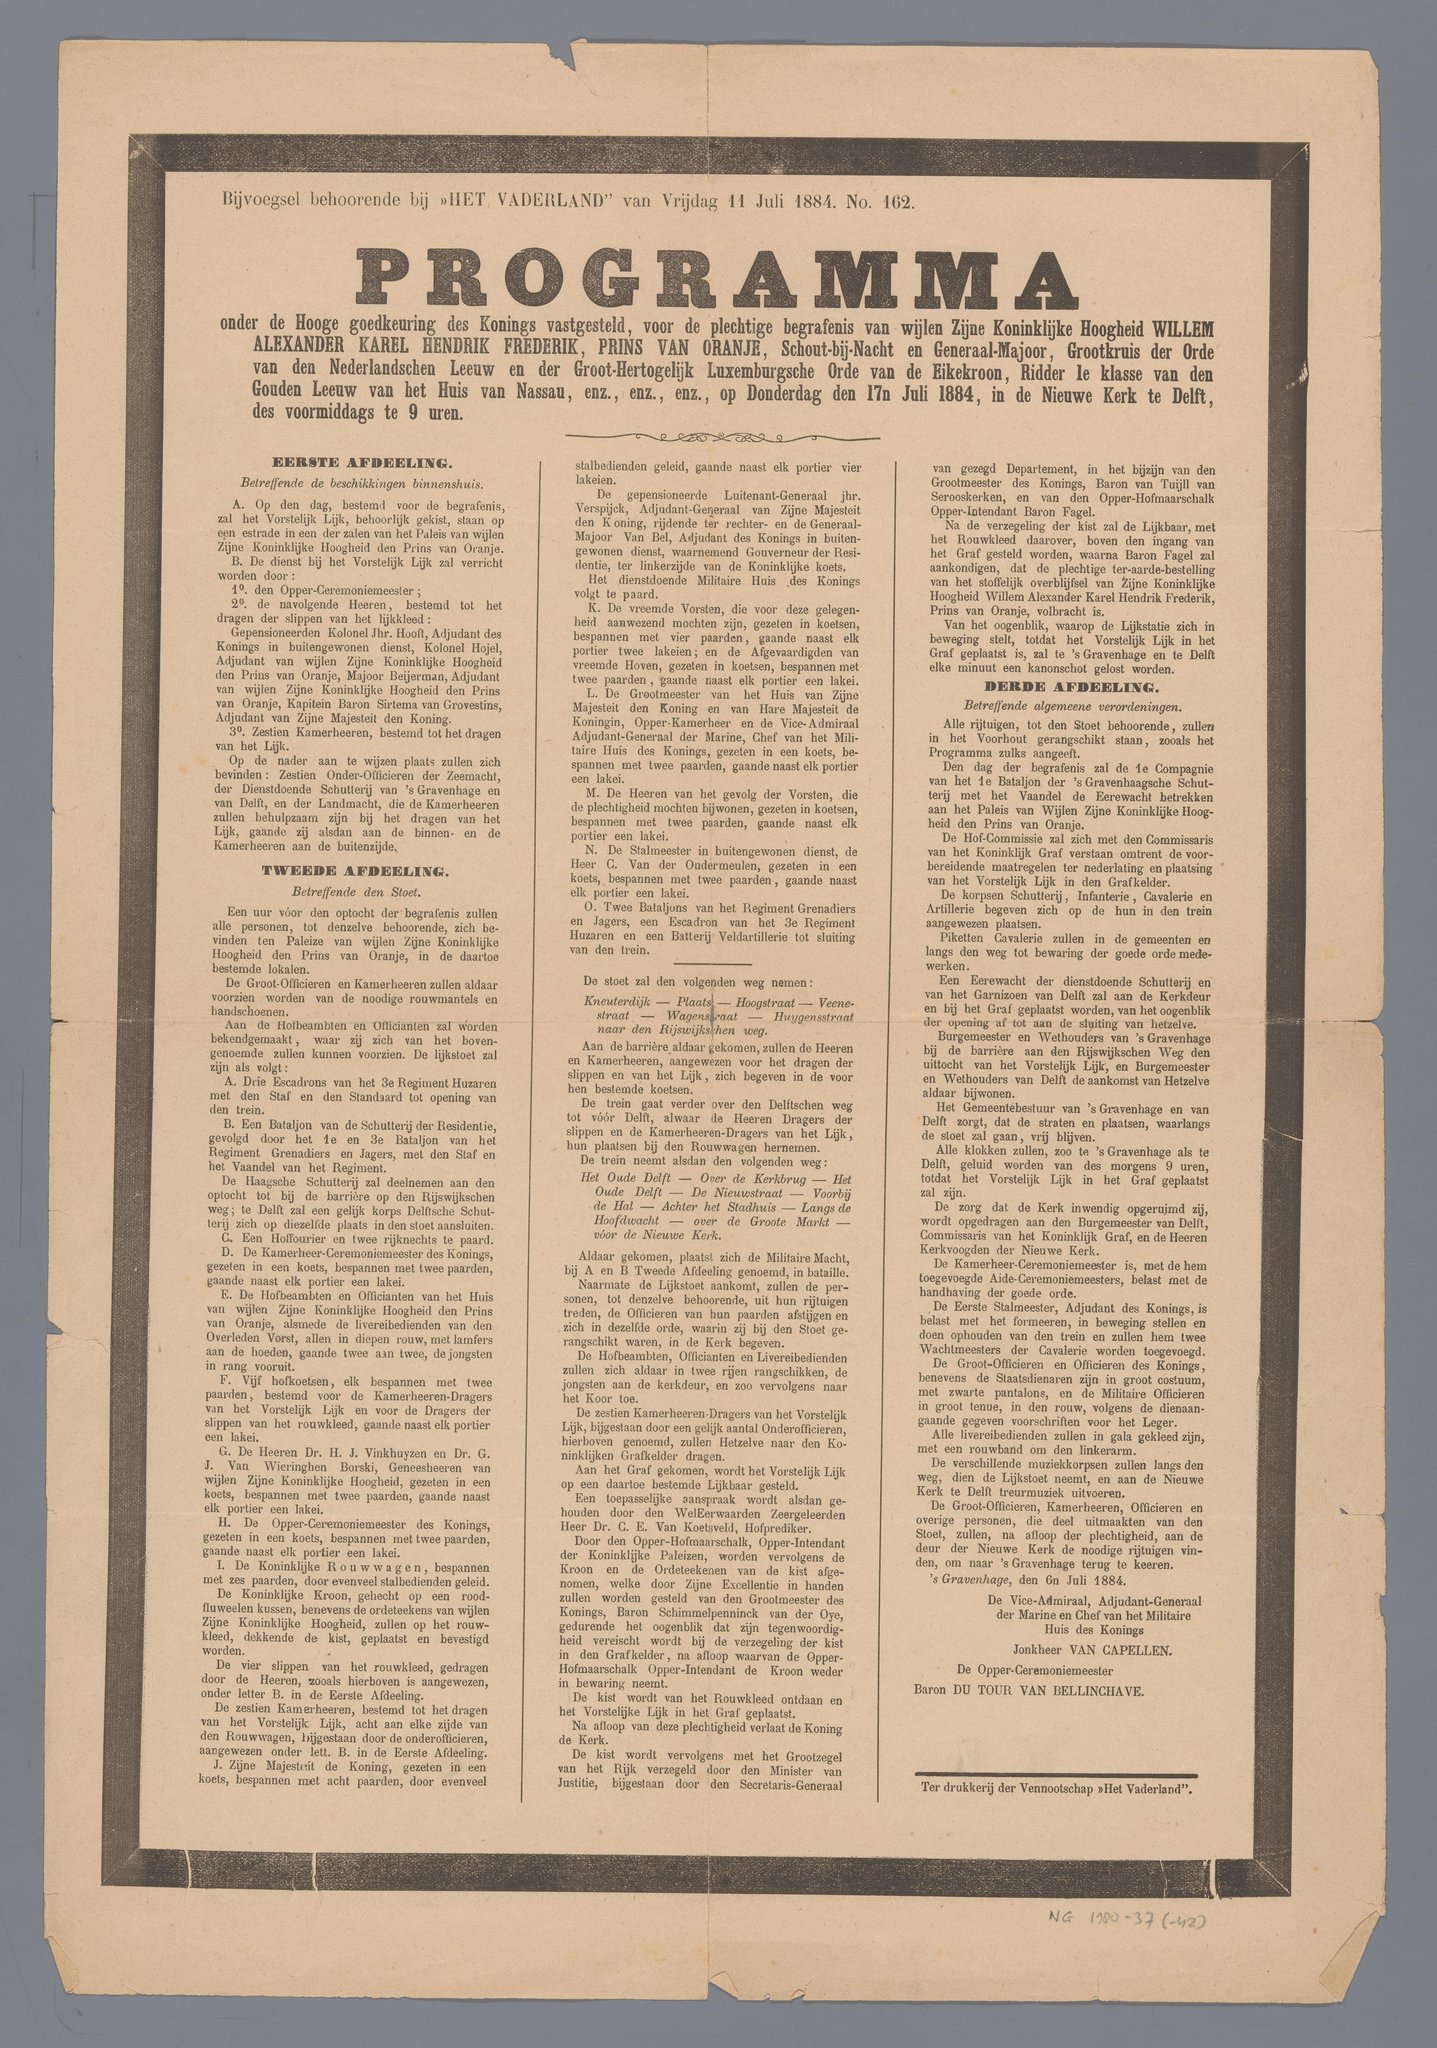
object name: newspaper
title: Programma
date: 1884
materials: paper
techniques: printing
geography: the hague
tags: the hague, netherlands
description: Bijvoegsel bij een krant, blad eenzijdig bedrukt, programma van de begrafenis van prins Alexander te Delft op 17-06-1884; vetgedrukte kop, tekst in drie kolommen.